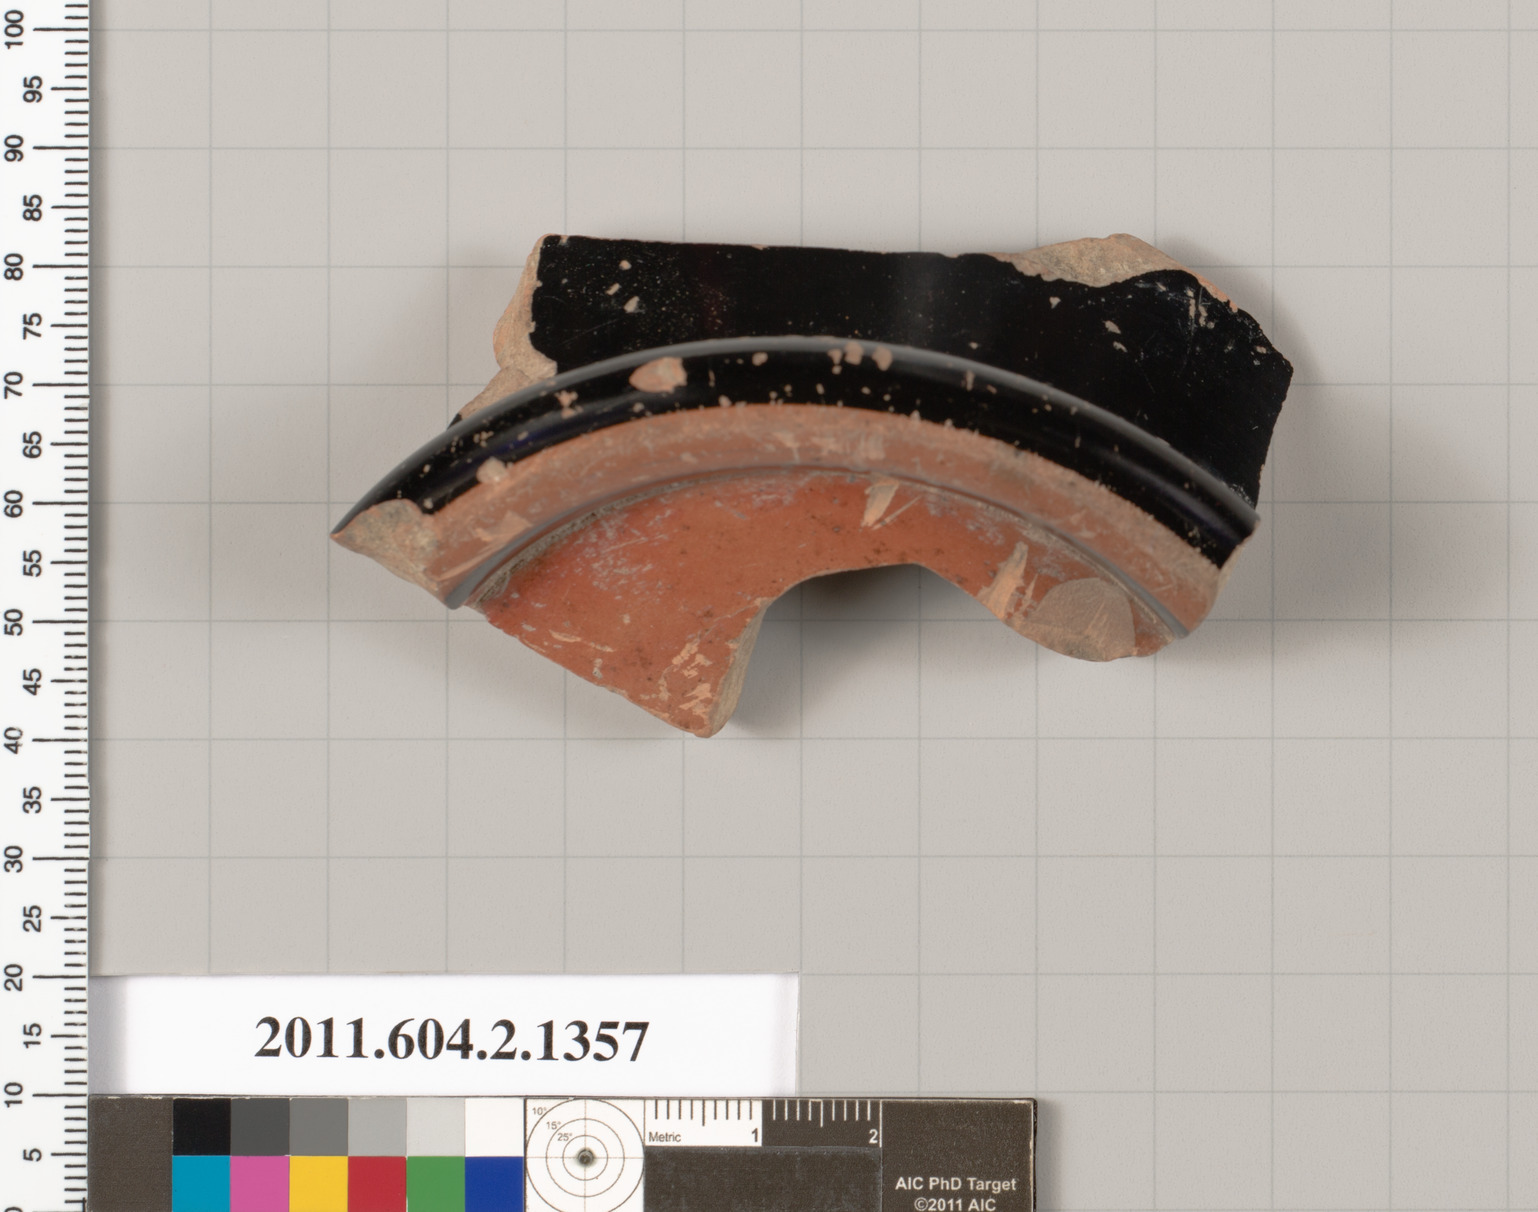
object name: skyphos fragment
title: Terracotta fragment of a skyphos (deep drinking cup)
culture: greek, attic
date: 475-451 BCE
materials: terracotta